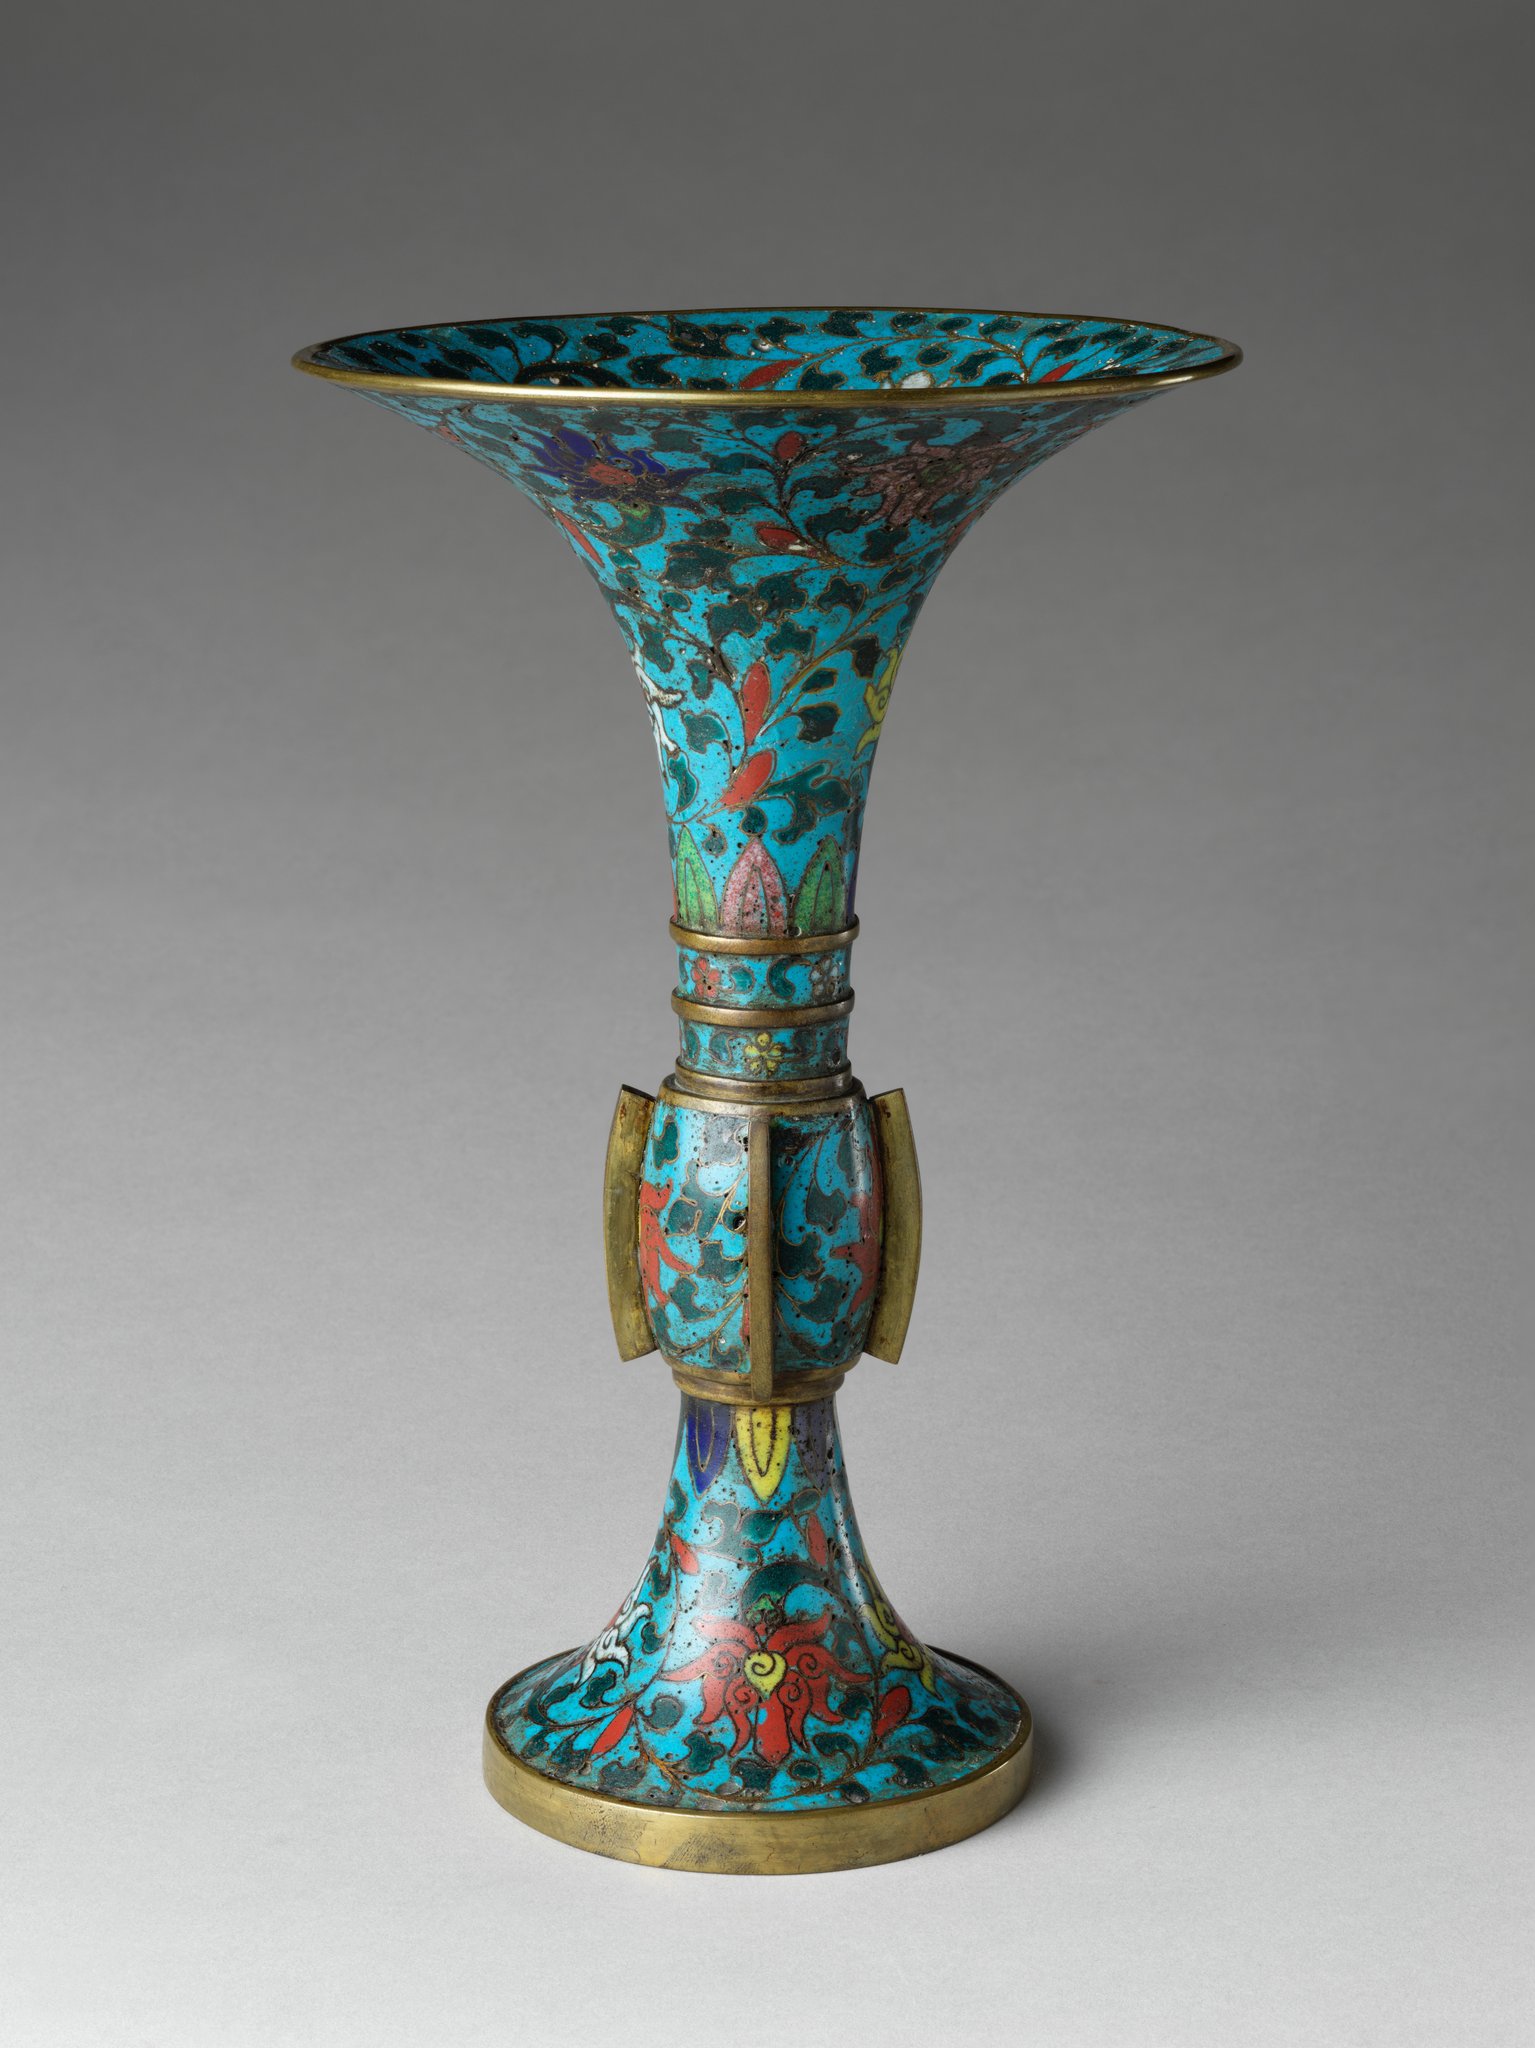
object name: vase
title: Vase in the form of an archaic wine vessel (gu)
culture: chinese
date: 1567-1633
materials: enamel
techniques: enamel